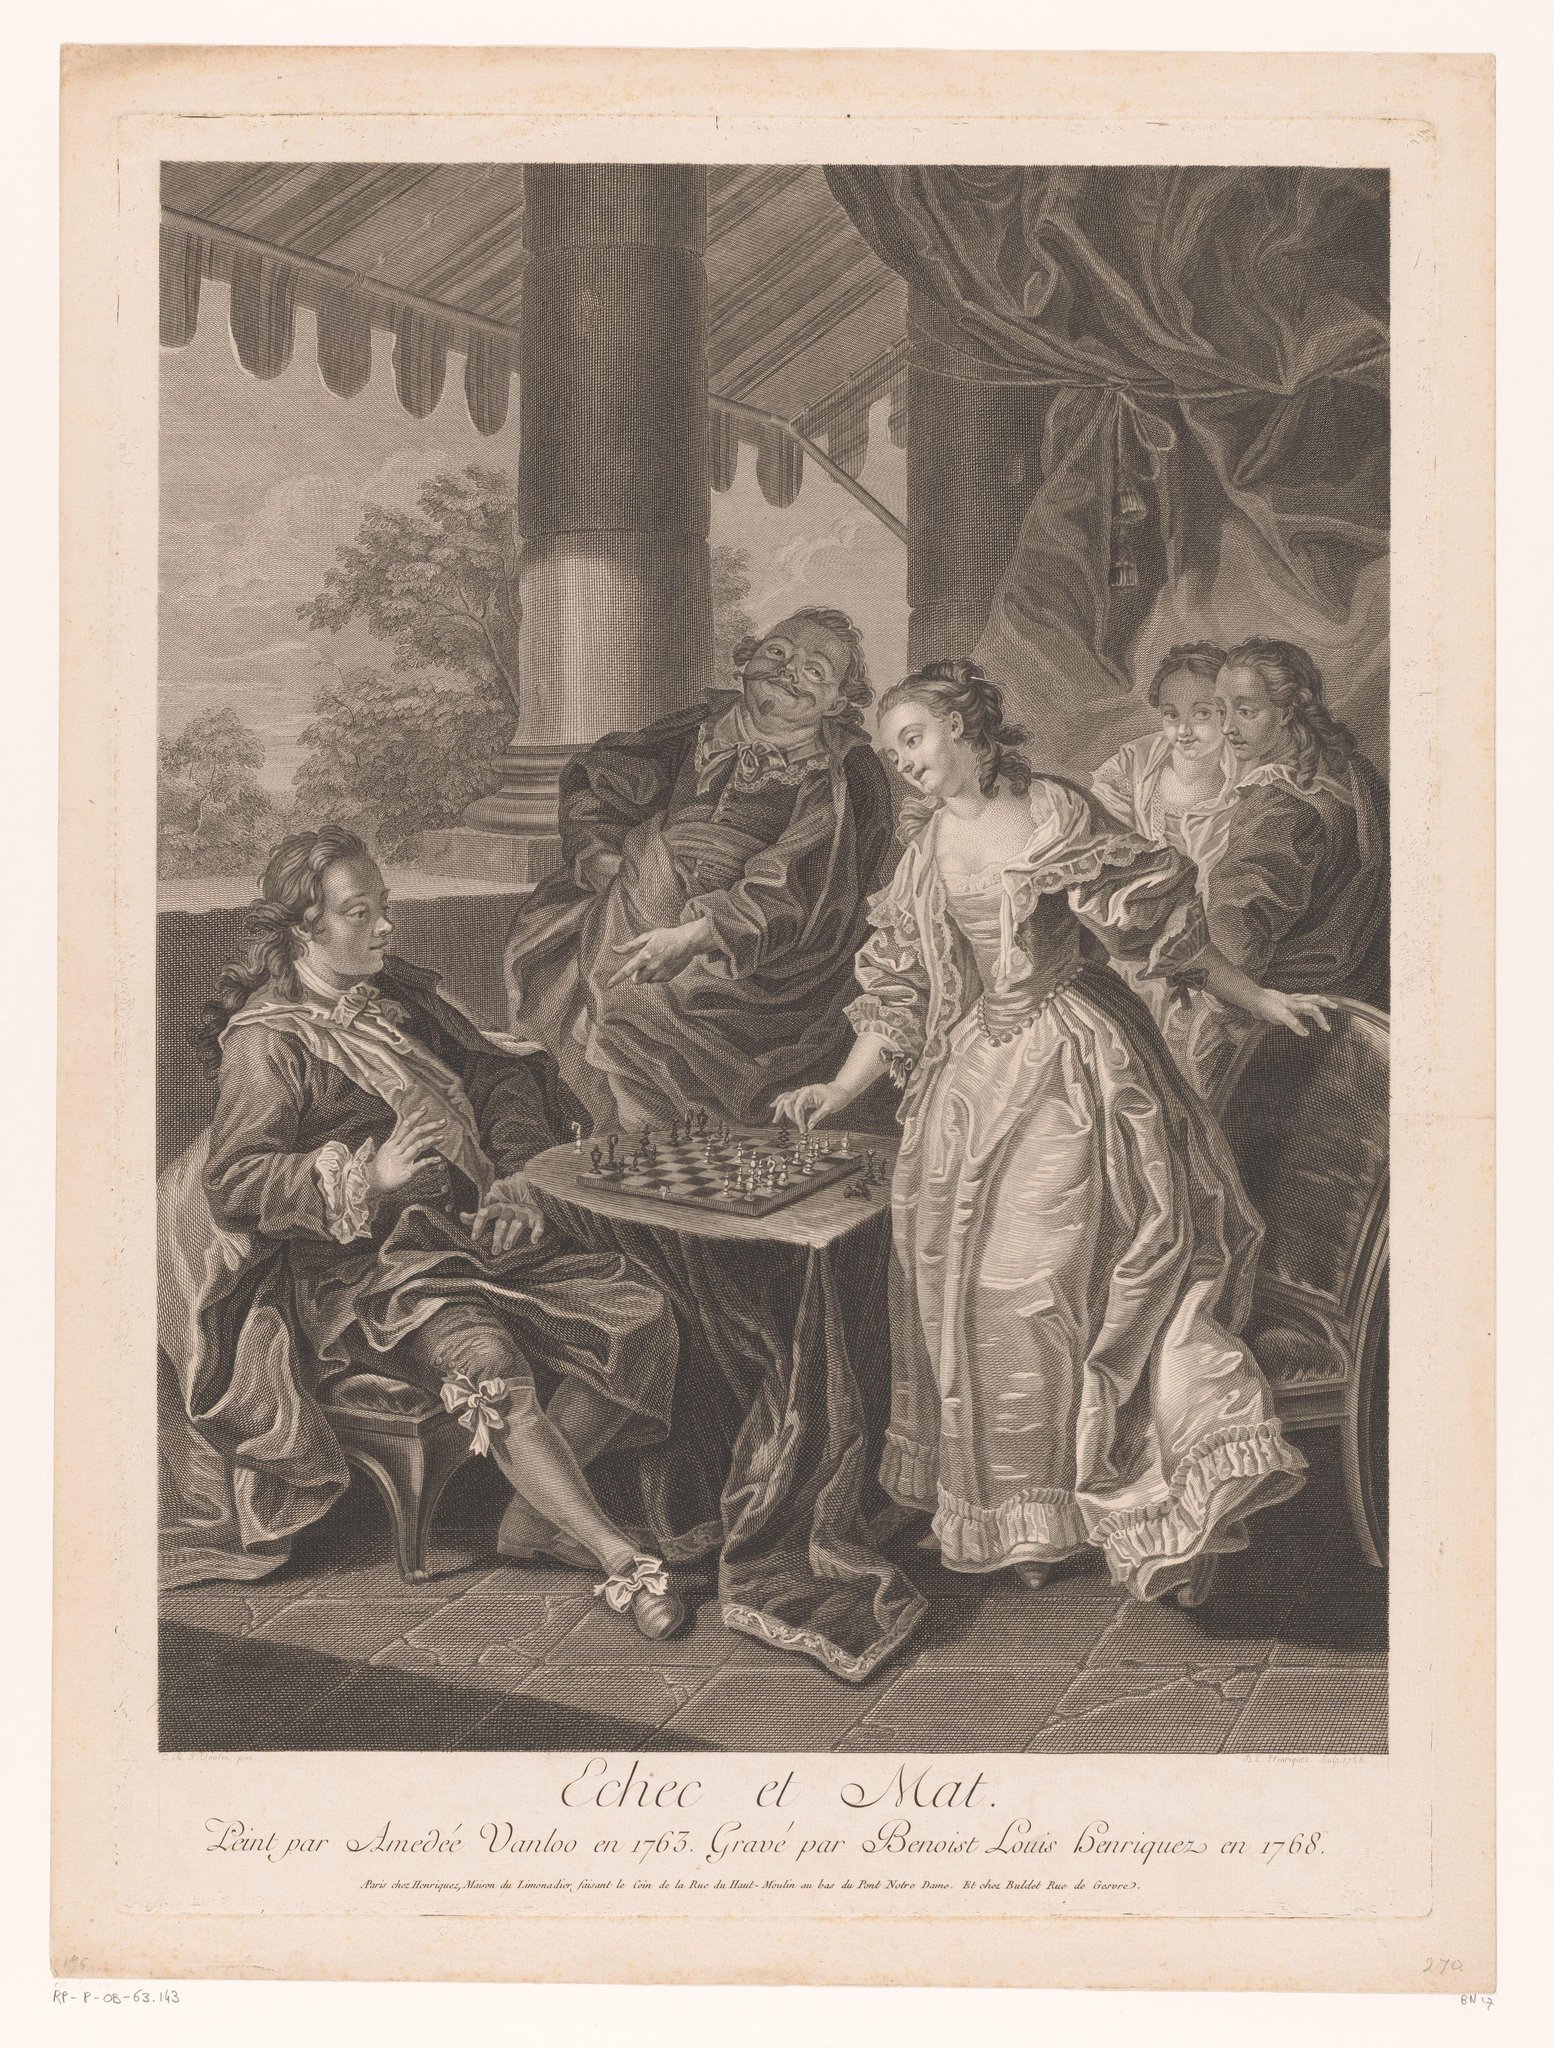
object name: print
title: Echec et Mat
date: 1768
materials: paper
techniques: engraving, etching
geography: paris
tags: man and woman playing chess, woman wins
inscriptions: collector's mark: Lugt 2228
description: Een vrouw zet een man schaakmat op een bordes.